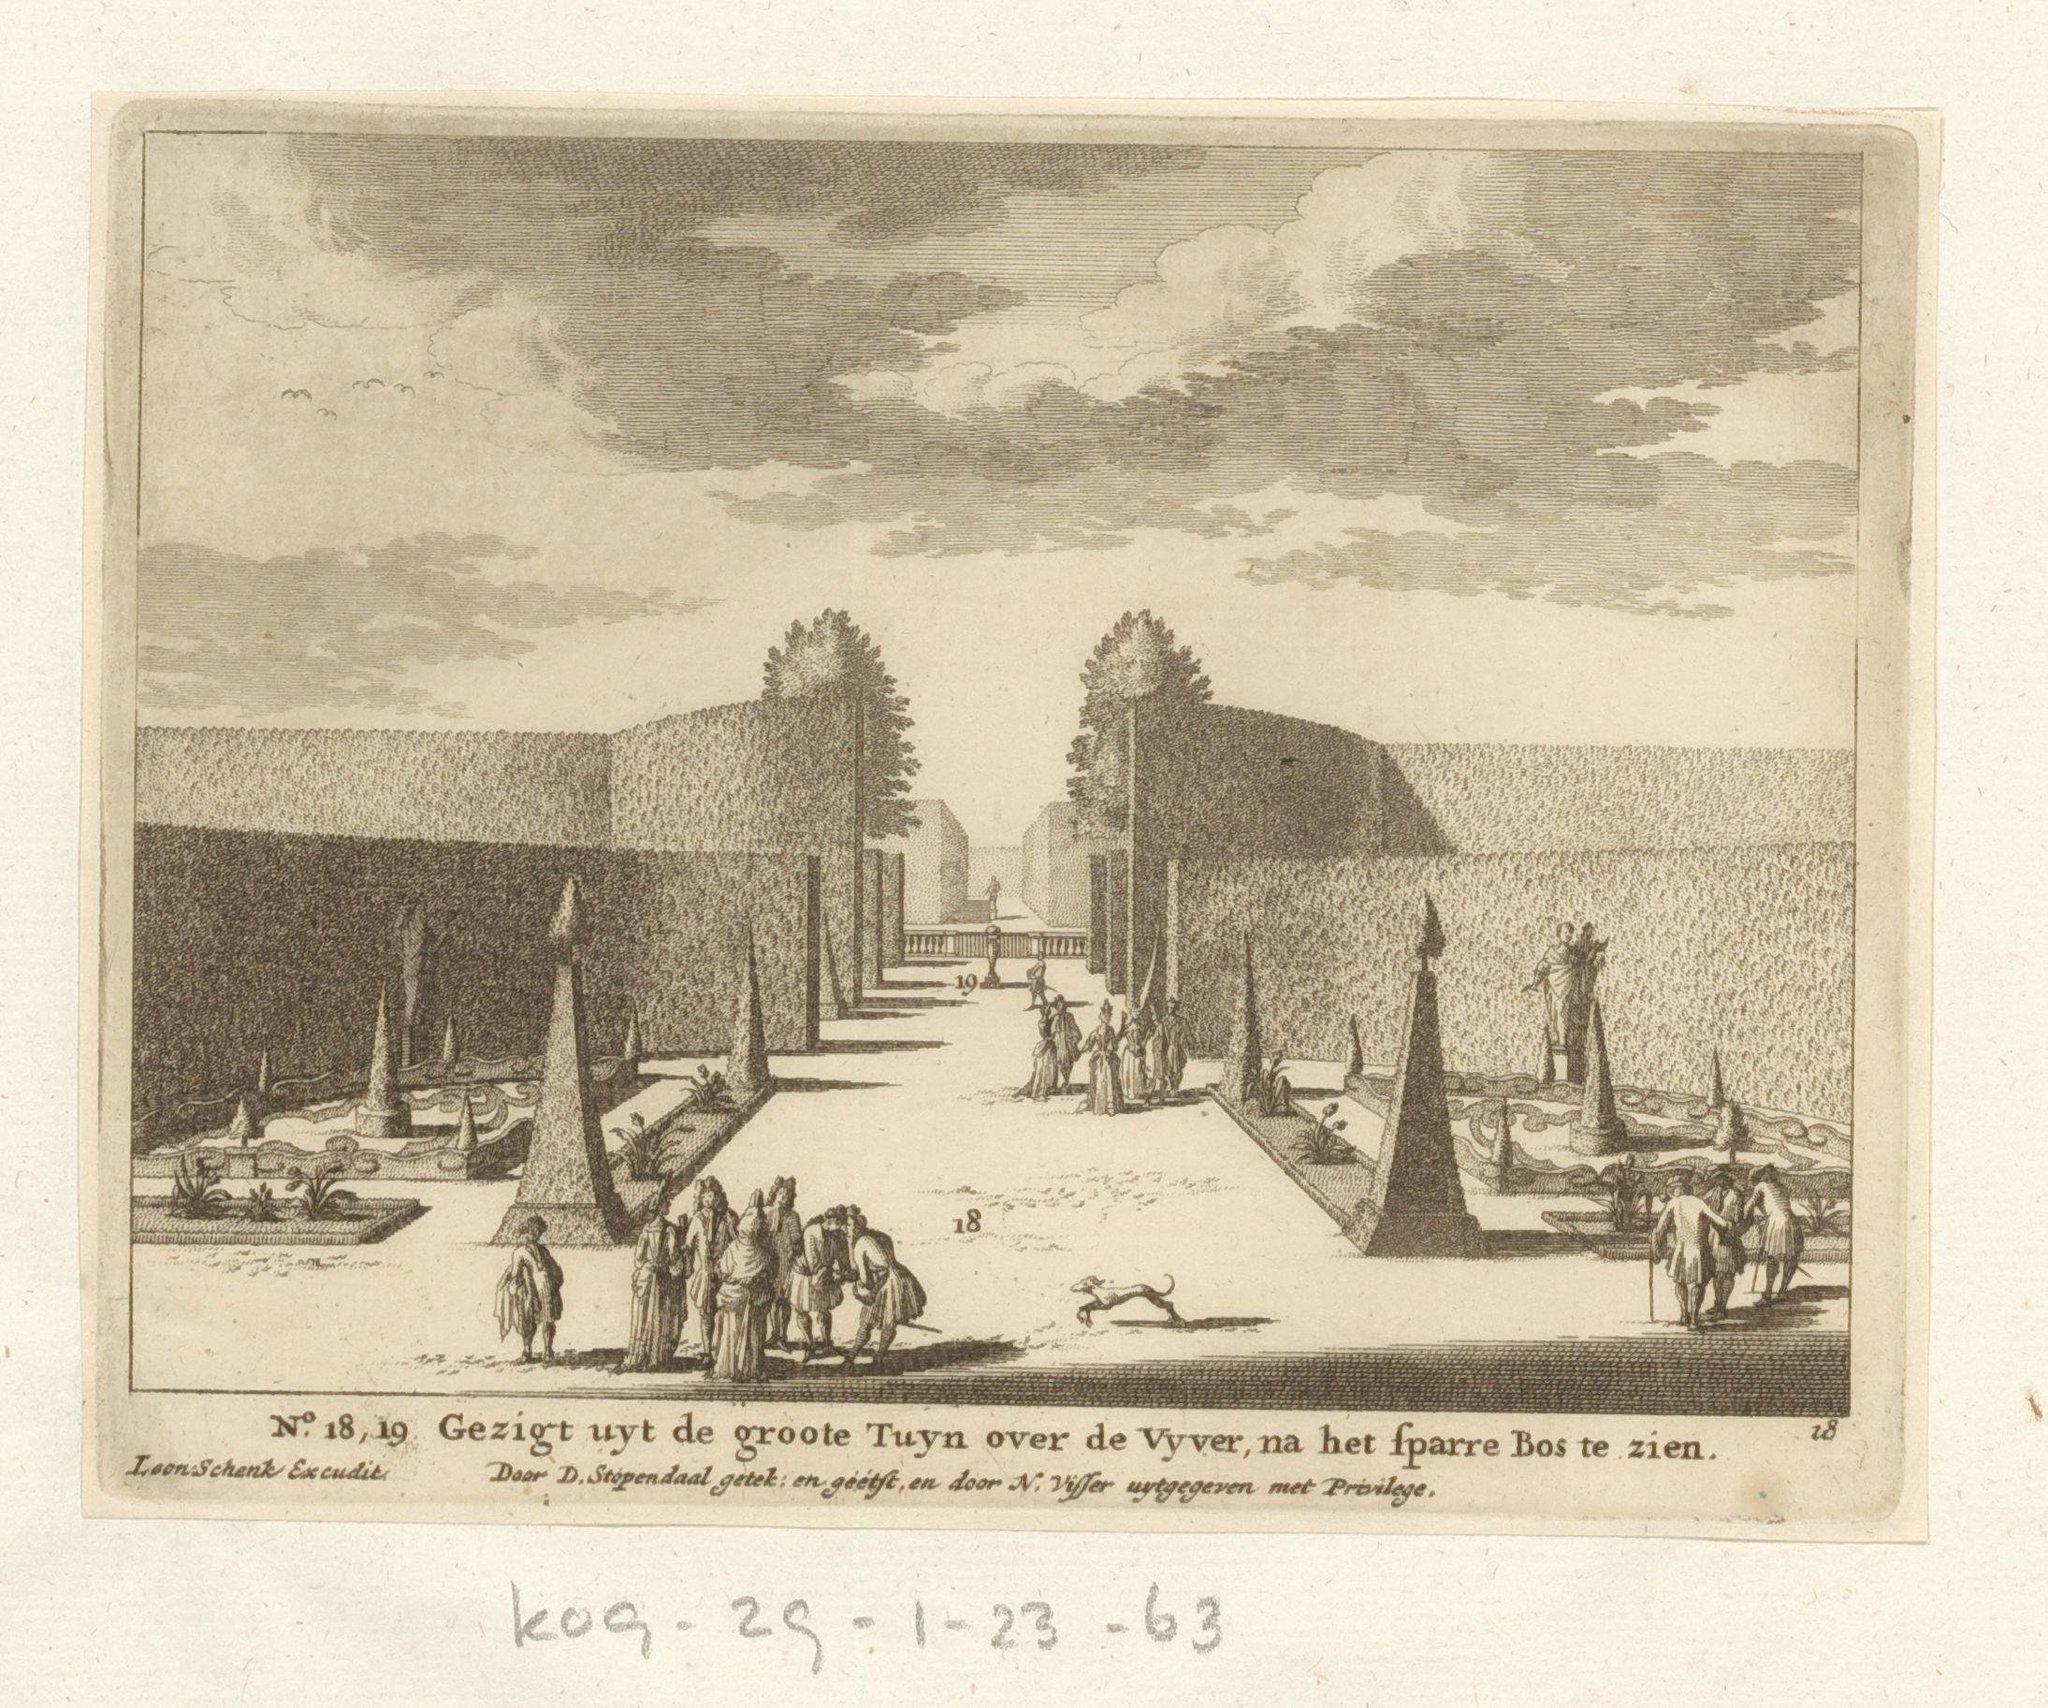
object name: print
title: Grote tuin op landgoed Clingendael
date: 1706-1767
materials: paper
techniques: engraving, etching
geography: amsterdam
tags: french or architectonic garden; formal garden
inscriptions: stamp, collector's mark: Lugt 1641, stamp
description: De grote tuin bij Huis Clingendael te Den Haag met bloemperken en hoge hagen. Op de voorgrond een elegant gezelschap. Onderwerpsrubrieken binnen de Atlas Zeden en Gewoonten: Zeden en Gewoonten in Engeren Zin, De Woning. Kastelen en buitenplaatsen. Holland.